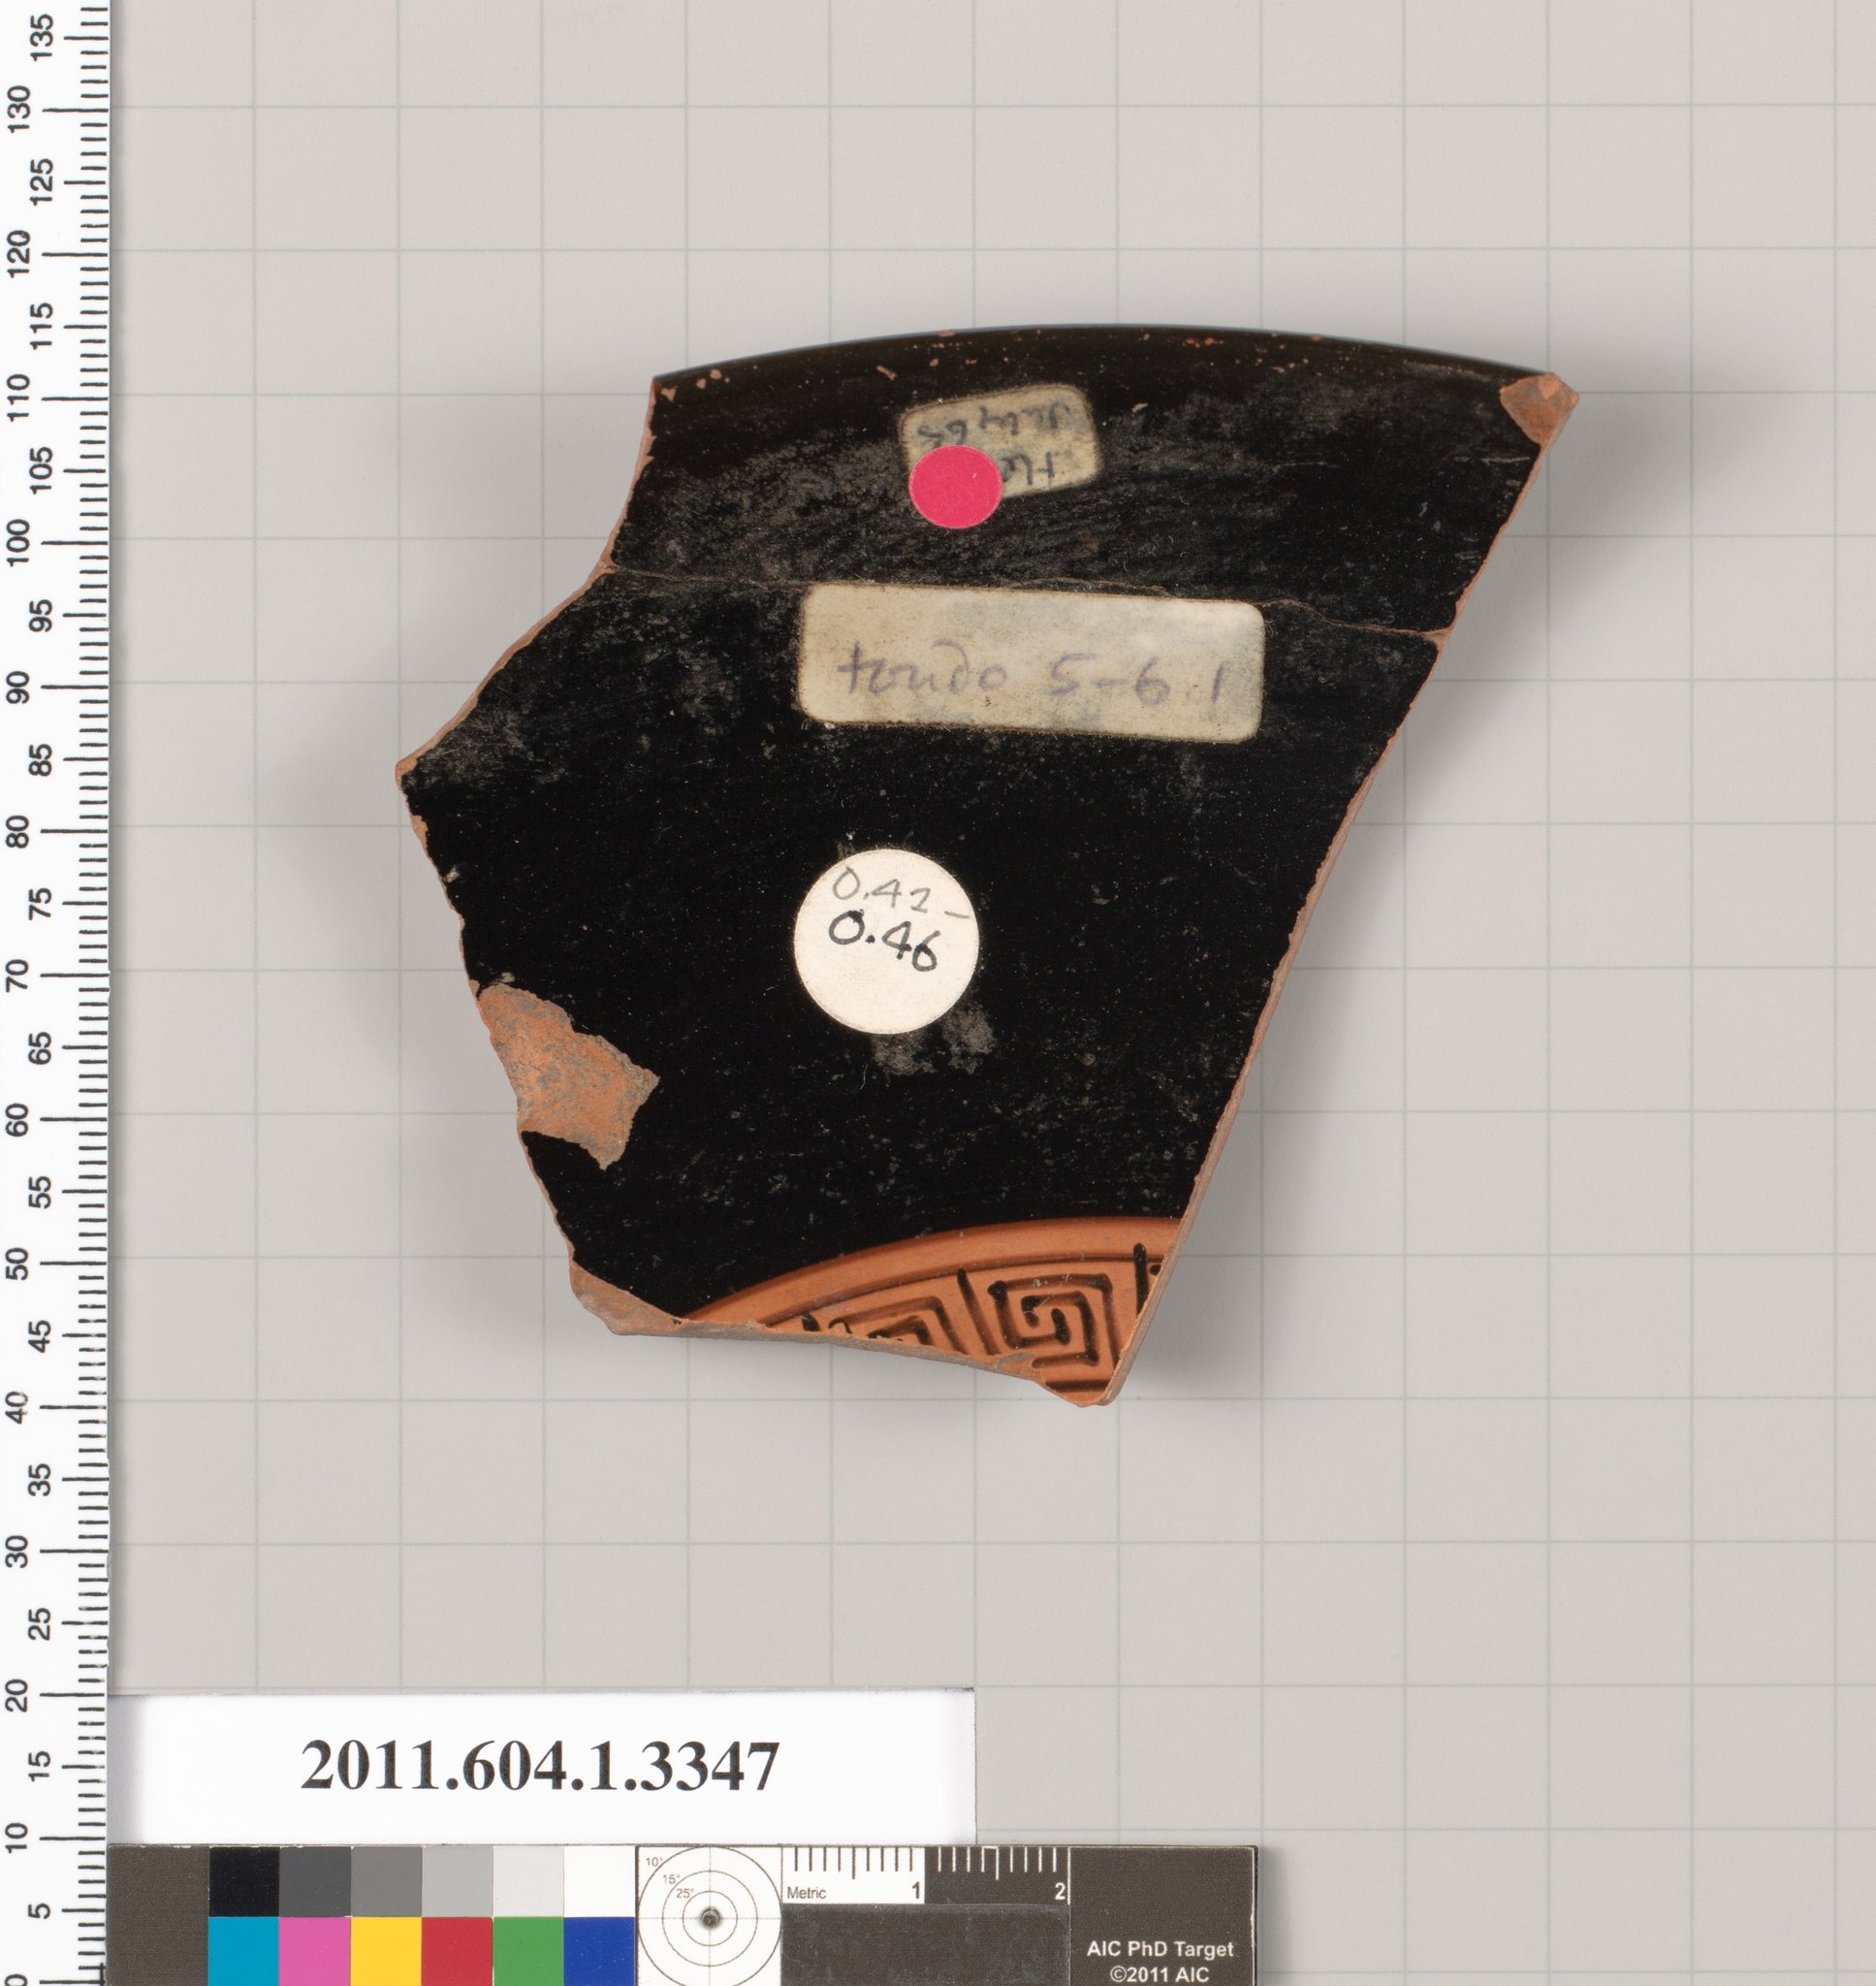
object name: kylix fragment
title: Terracotta fragment of a kylix (drinking cup)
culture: greek, attic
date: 500-470 BCE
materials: terracotta